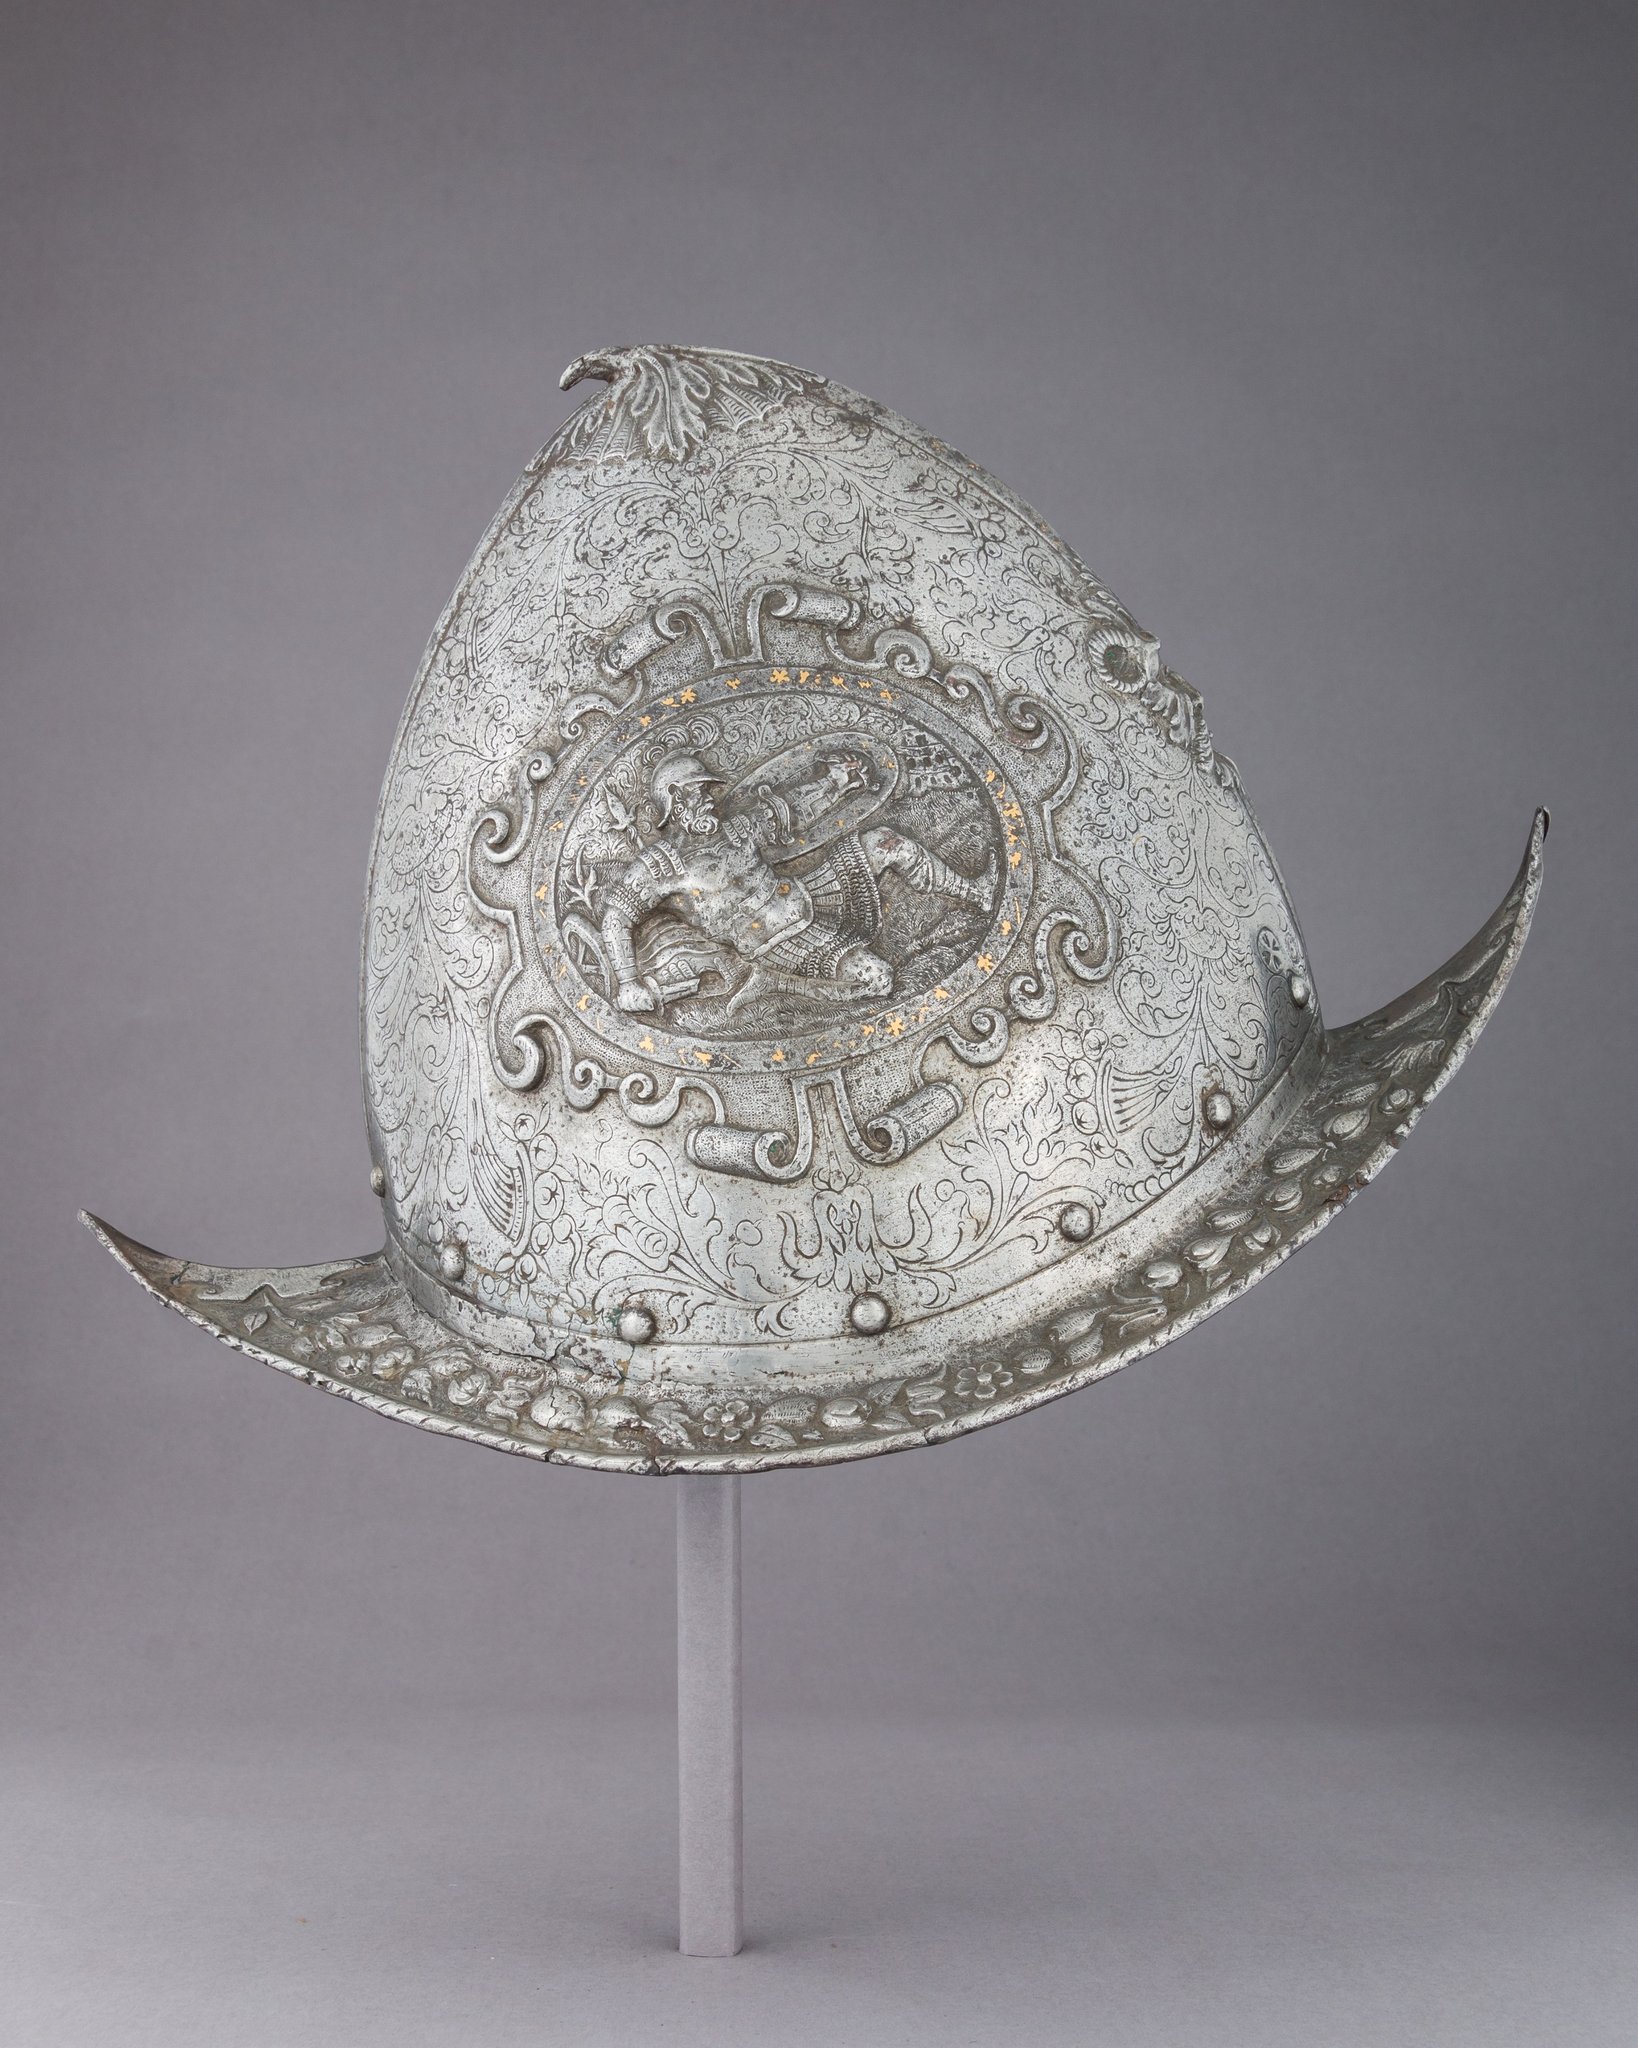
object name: morion cabasset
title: Morion-Cabasset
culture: italian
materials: gold, steel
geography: italy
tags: men